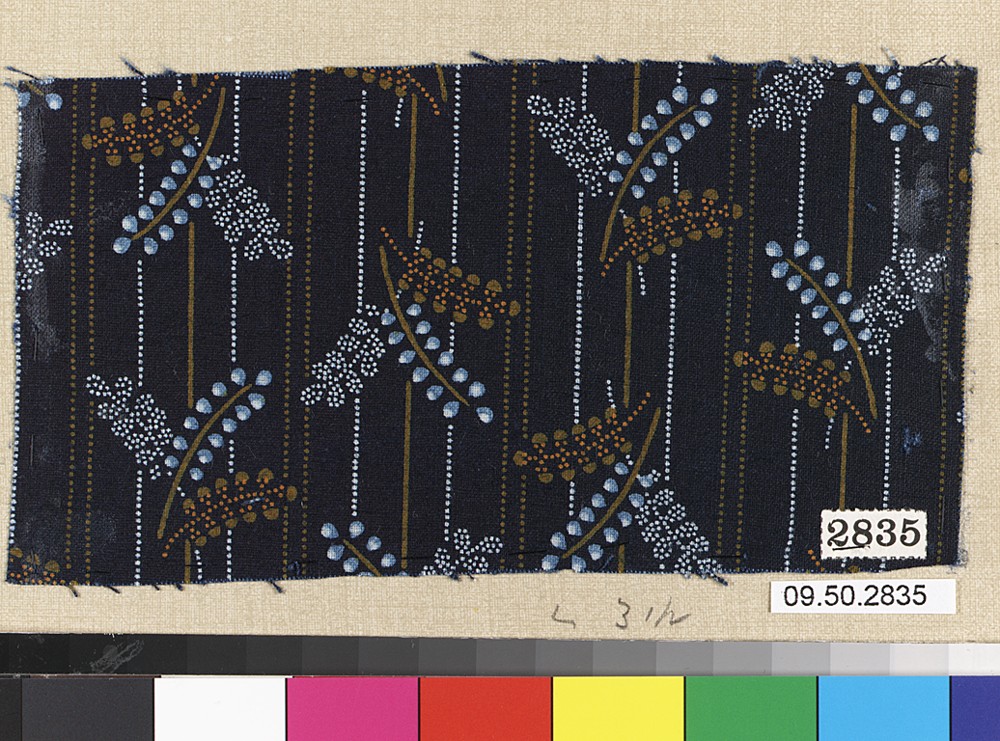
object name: piece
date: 1801-1900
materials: cotton